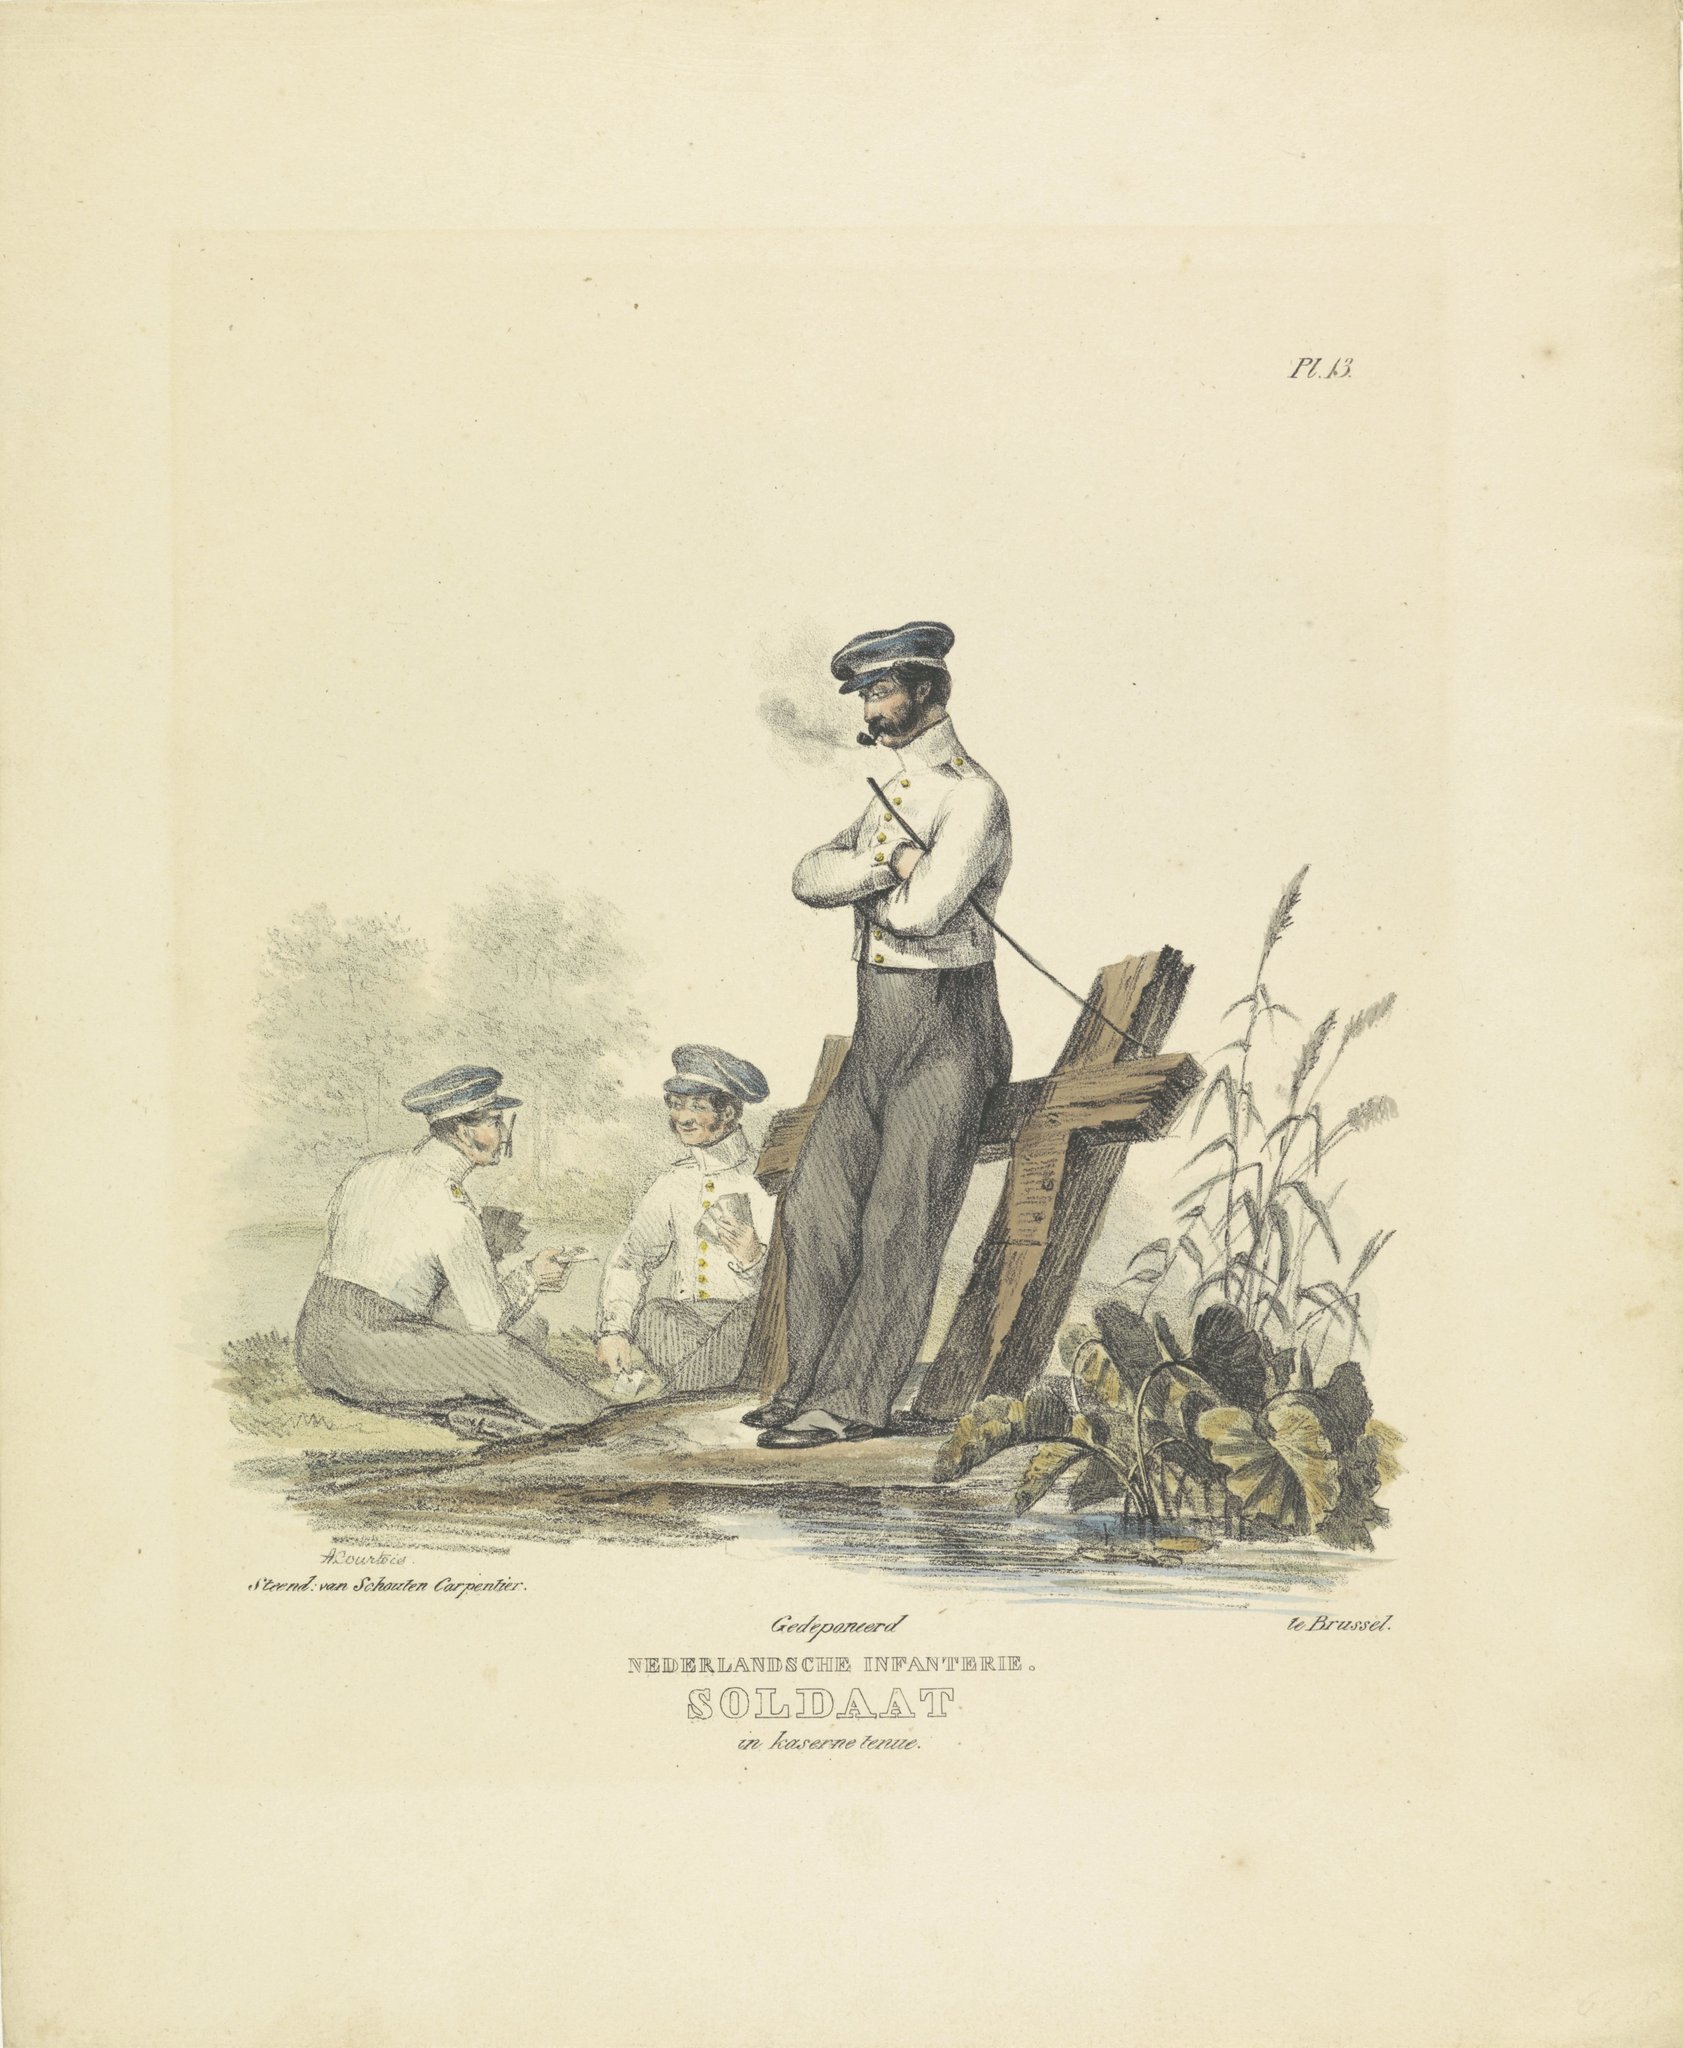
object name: print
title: Nederlandsche Infanterie. Soldaat in kaserne tenue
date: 1825-1827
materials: paper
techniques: hand coloring, lithograph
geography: brussels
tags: (military) uniforms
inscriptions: collector's mark: Lugt 2228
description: Uniformvoorstelling van een soldaat van de infanterie in kazernetenue. Genummerd rechtsboven: Pl. 13. Onderdeel van de reeks van 53 platen van uniformen van de militairen van het Koninkrijk der Nederlanden in de periode 1820-1825.